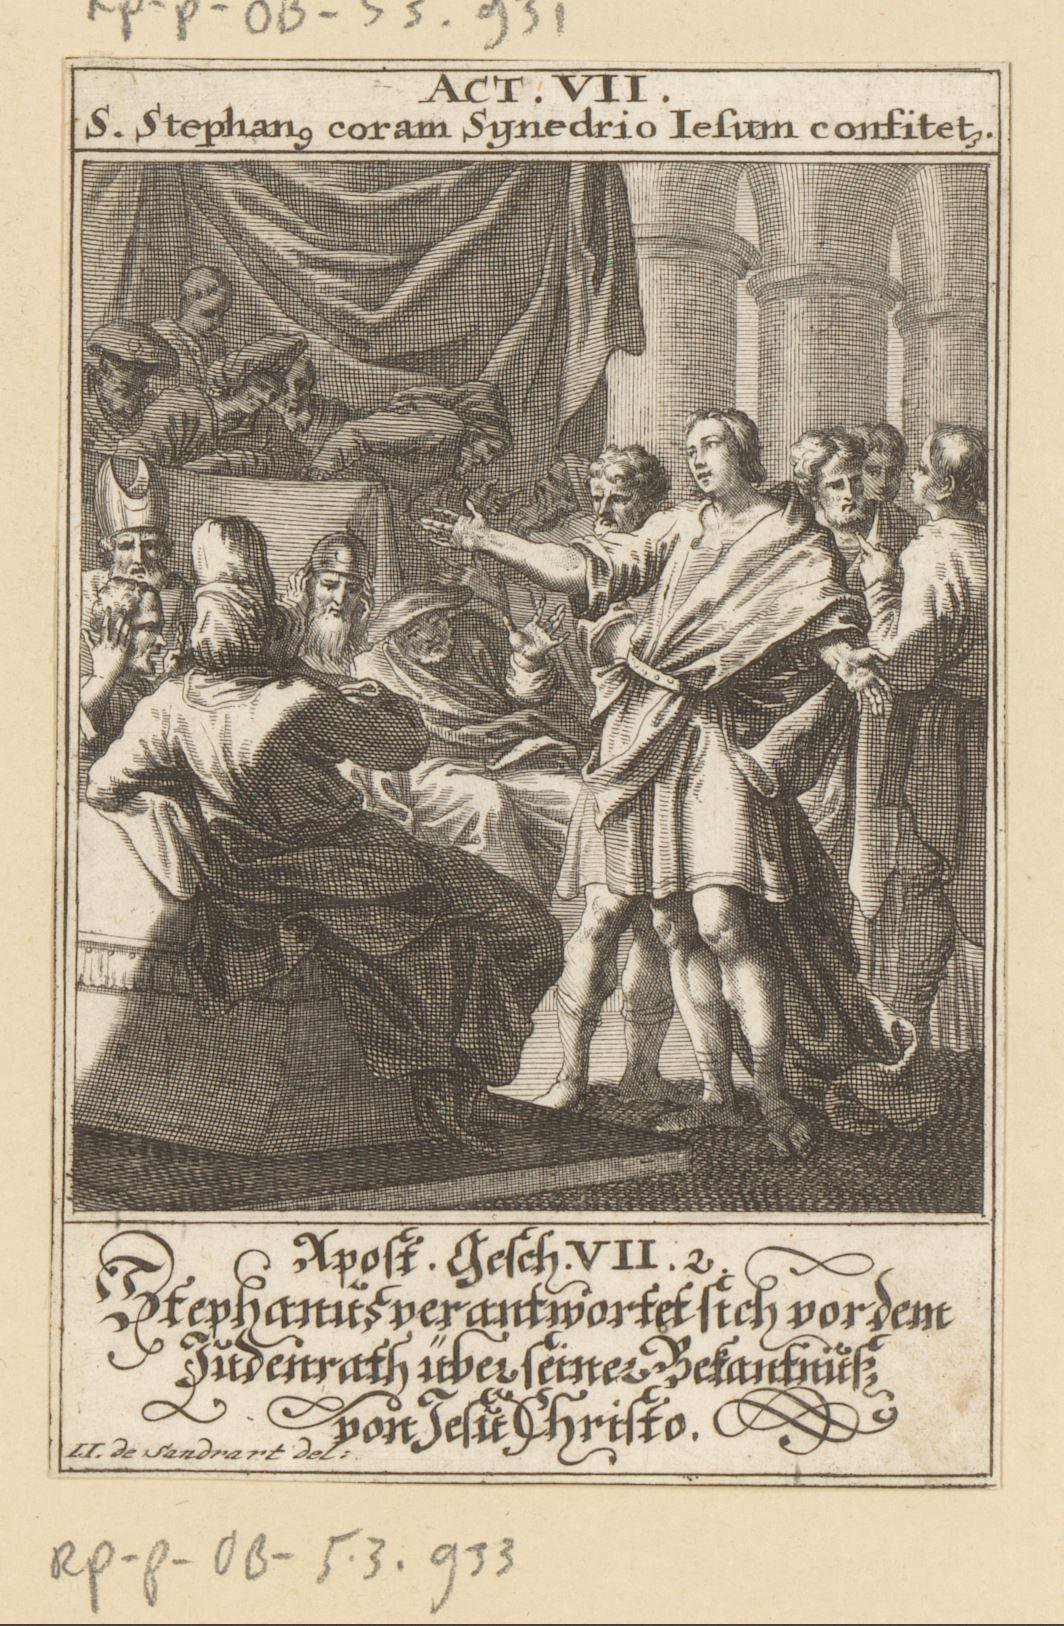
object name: print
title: Heilige Stefanus voor de raad der Joden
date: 1697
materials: paper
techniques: etching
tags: stephen before the sanhedrin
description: Prent ook gebruikt in: Biblia ectypa : Bildnussen auss Heiliger Schrifft. Regensburg: Chr. Wiegel, 1697.